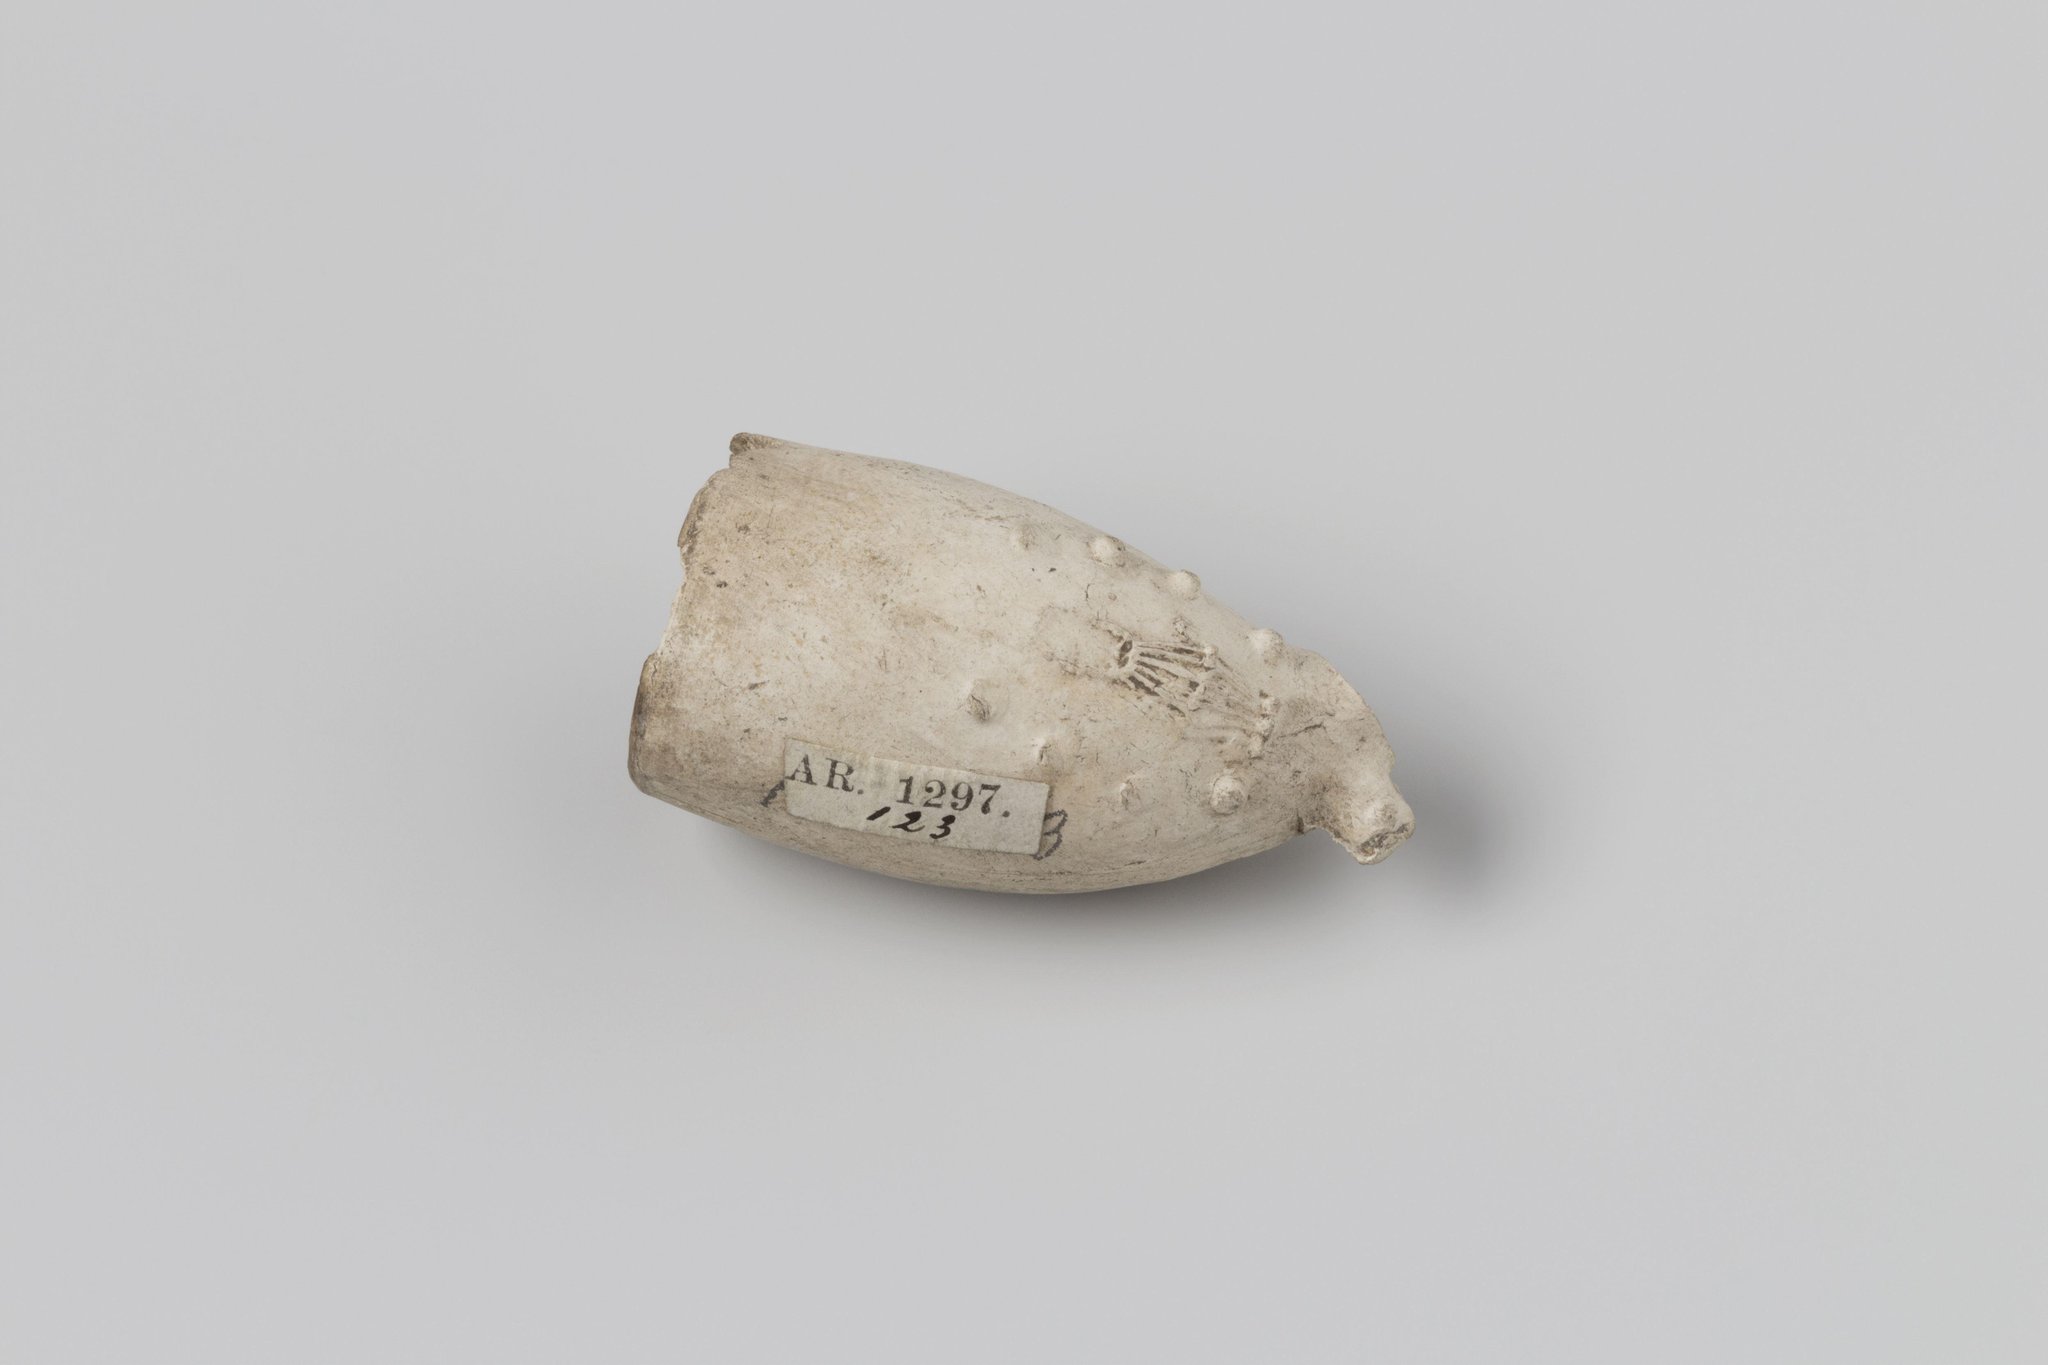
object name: fragment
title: Fragment pijpenkop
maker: Anonymous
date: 1750-1800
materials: clay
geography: netherlands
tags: directeur, hoogleraar, caspar jacob christiaan reuvens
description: Fragment pijpenkop met eierkorf binnen acht stippen. Van de opgravingen op de Hofstede Arentsburg 1827-1831 onder toezicht van Professor Reuvens.